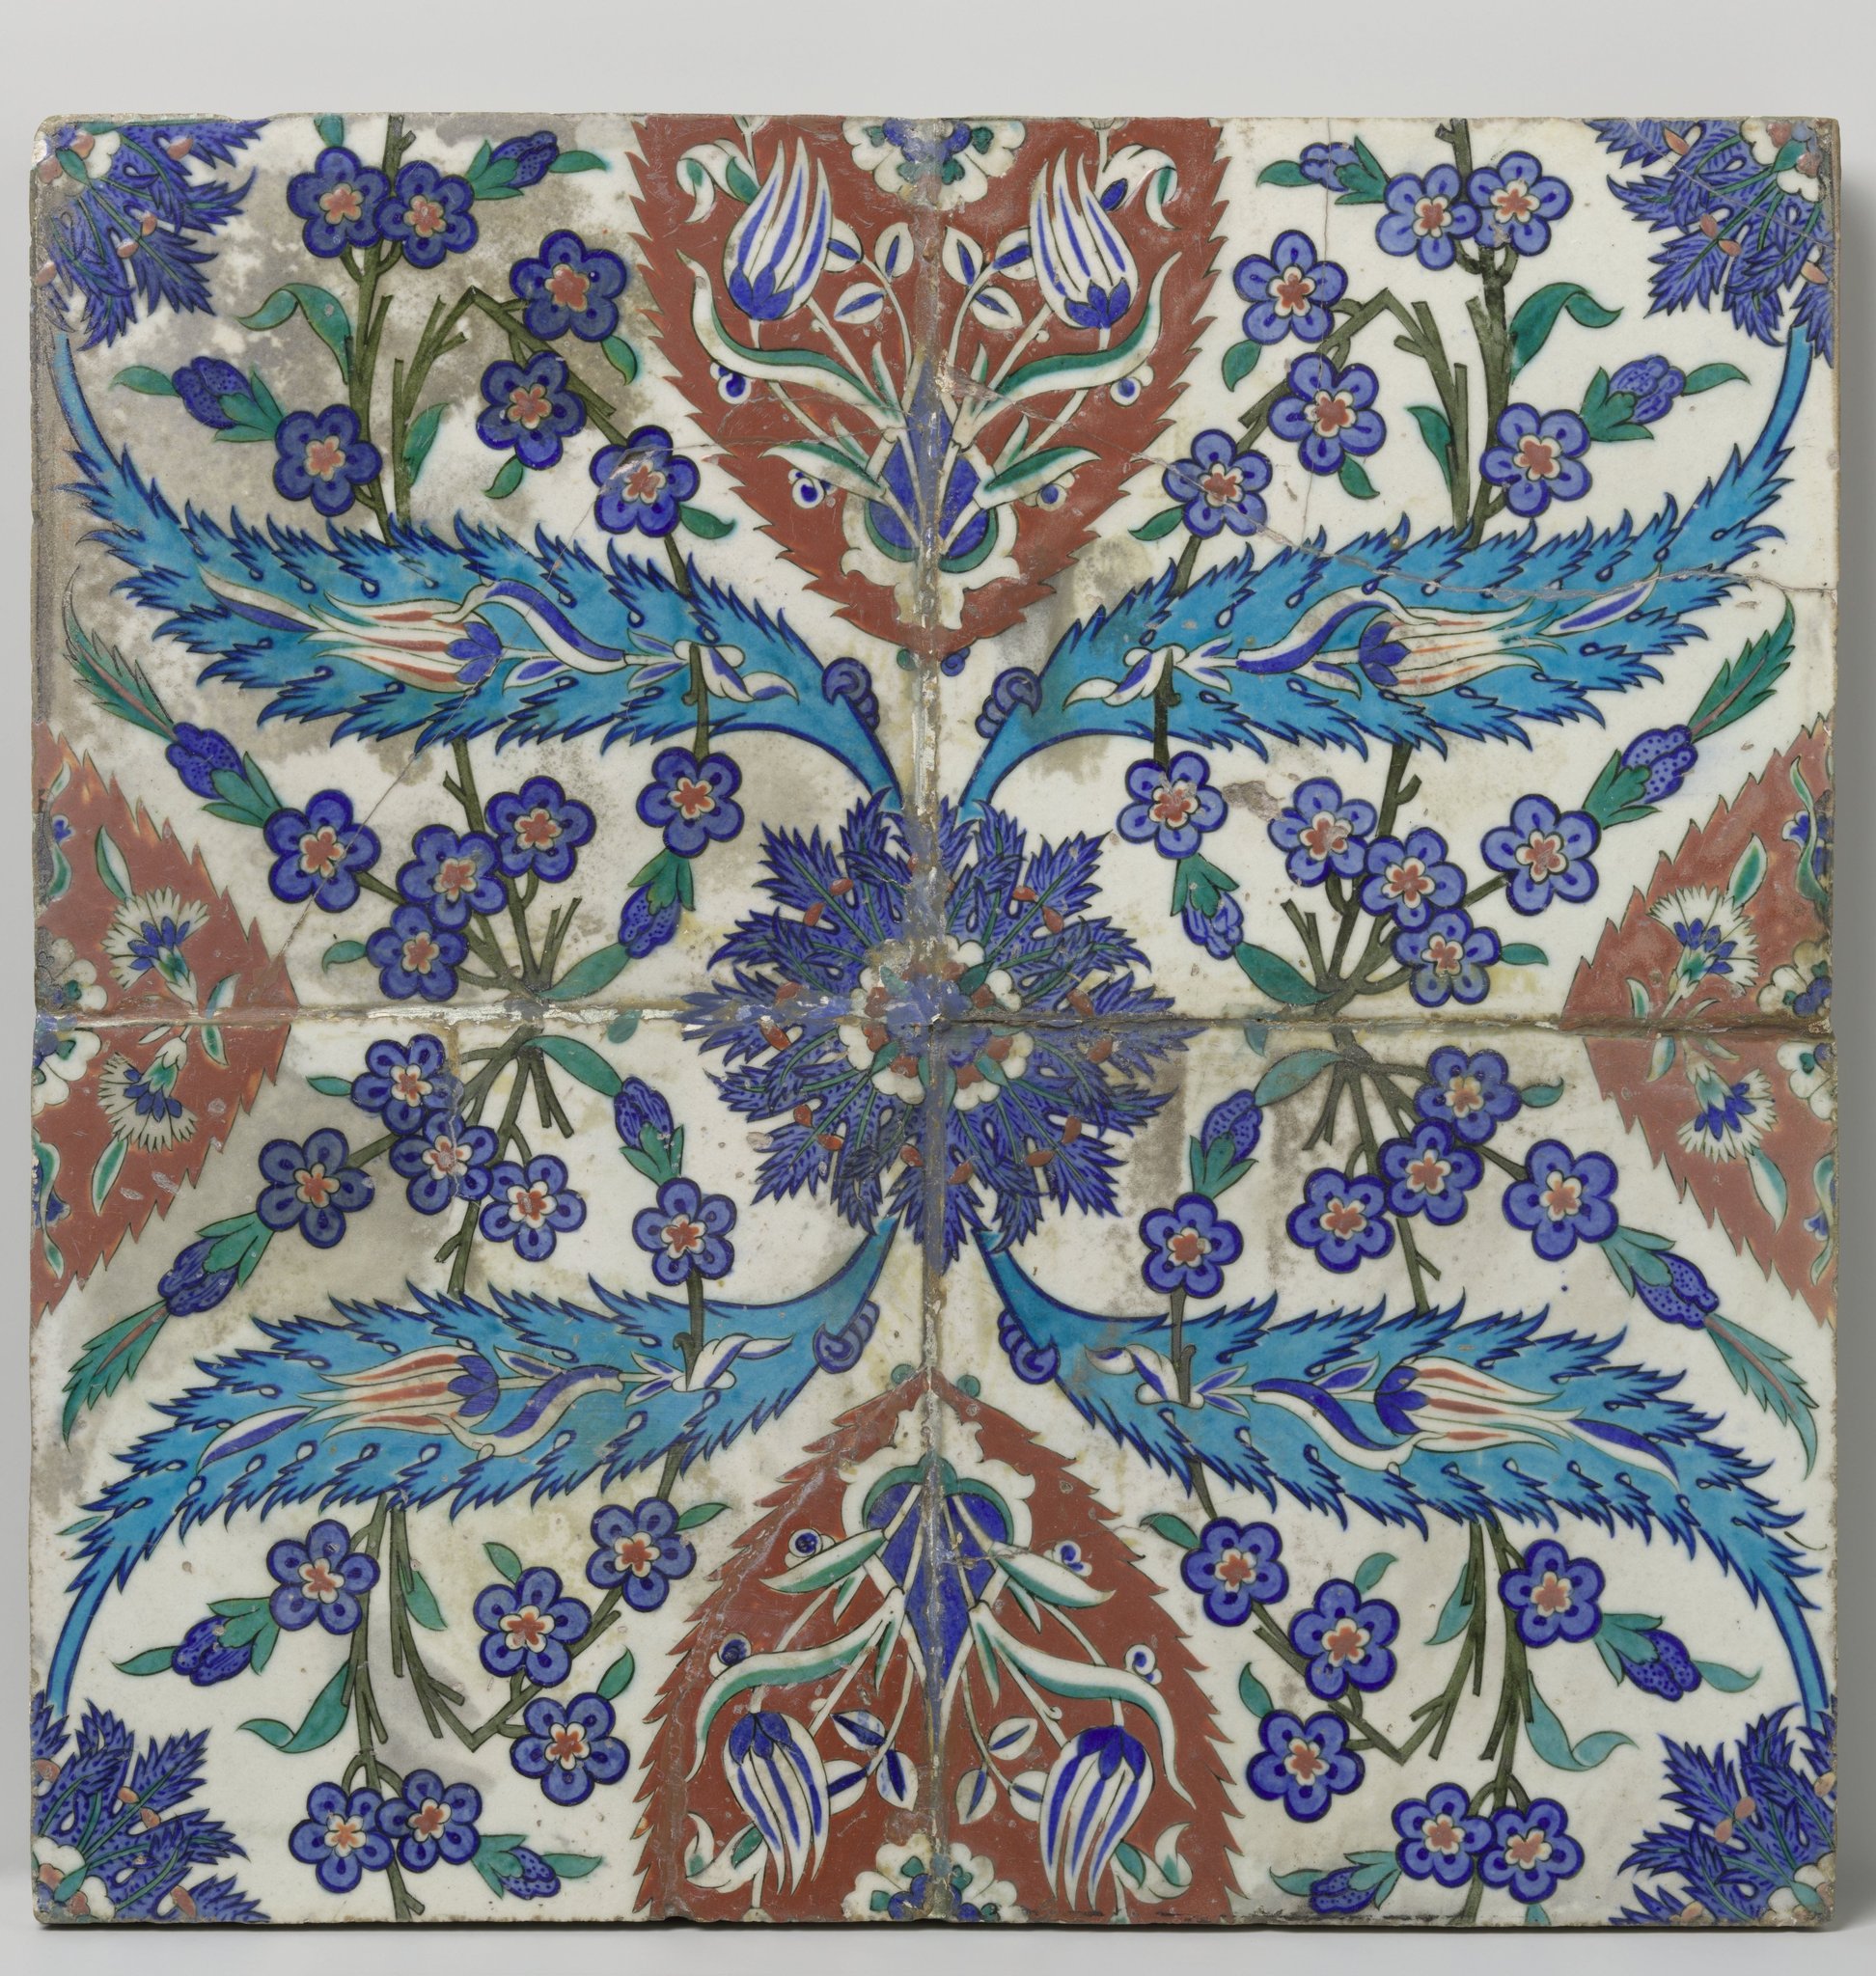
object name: tile tableau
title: Tegeltableau van vier met een samenhangend patroon van palmetten, bladvormen en bloemen versierde tegels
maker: Anonymous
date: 1500-1600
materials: earthenware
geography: iznik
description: Tegeltableau van vier met een samenhangend patroon van palmetten, bladvormen en bloemen versierde tegels. Op iedere tegel één palmetblad. Met vier te zamen vormen deze palmetten van turkoois blauw het kader waarbinnen een groot rood getand blad als middenstuk is gevat. De palmetten en bladen zelf zijn bezet met bloemvormen, tulpen, rozetvormige kleine bloemen en bladen. De witte grond vertoont een tekening van blauwe rozetvormige kleine bloemen ontspruitend aan doorlopende stengels. Het geheel in donker en lichter blauw, nuance ultramarijn, turkoois blauw en rood op witte grond. Turks. Voor een deel is het wit in de grond bezoedeld door een vetvlek onder het glazuur.